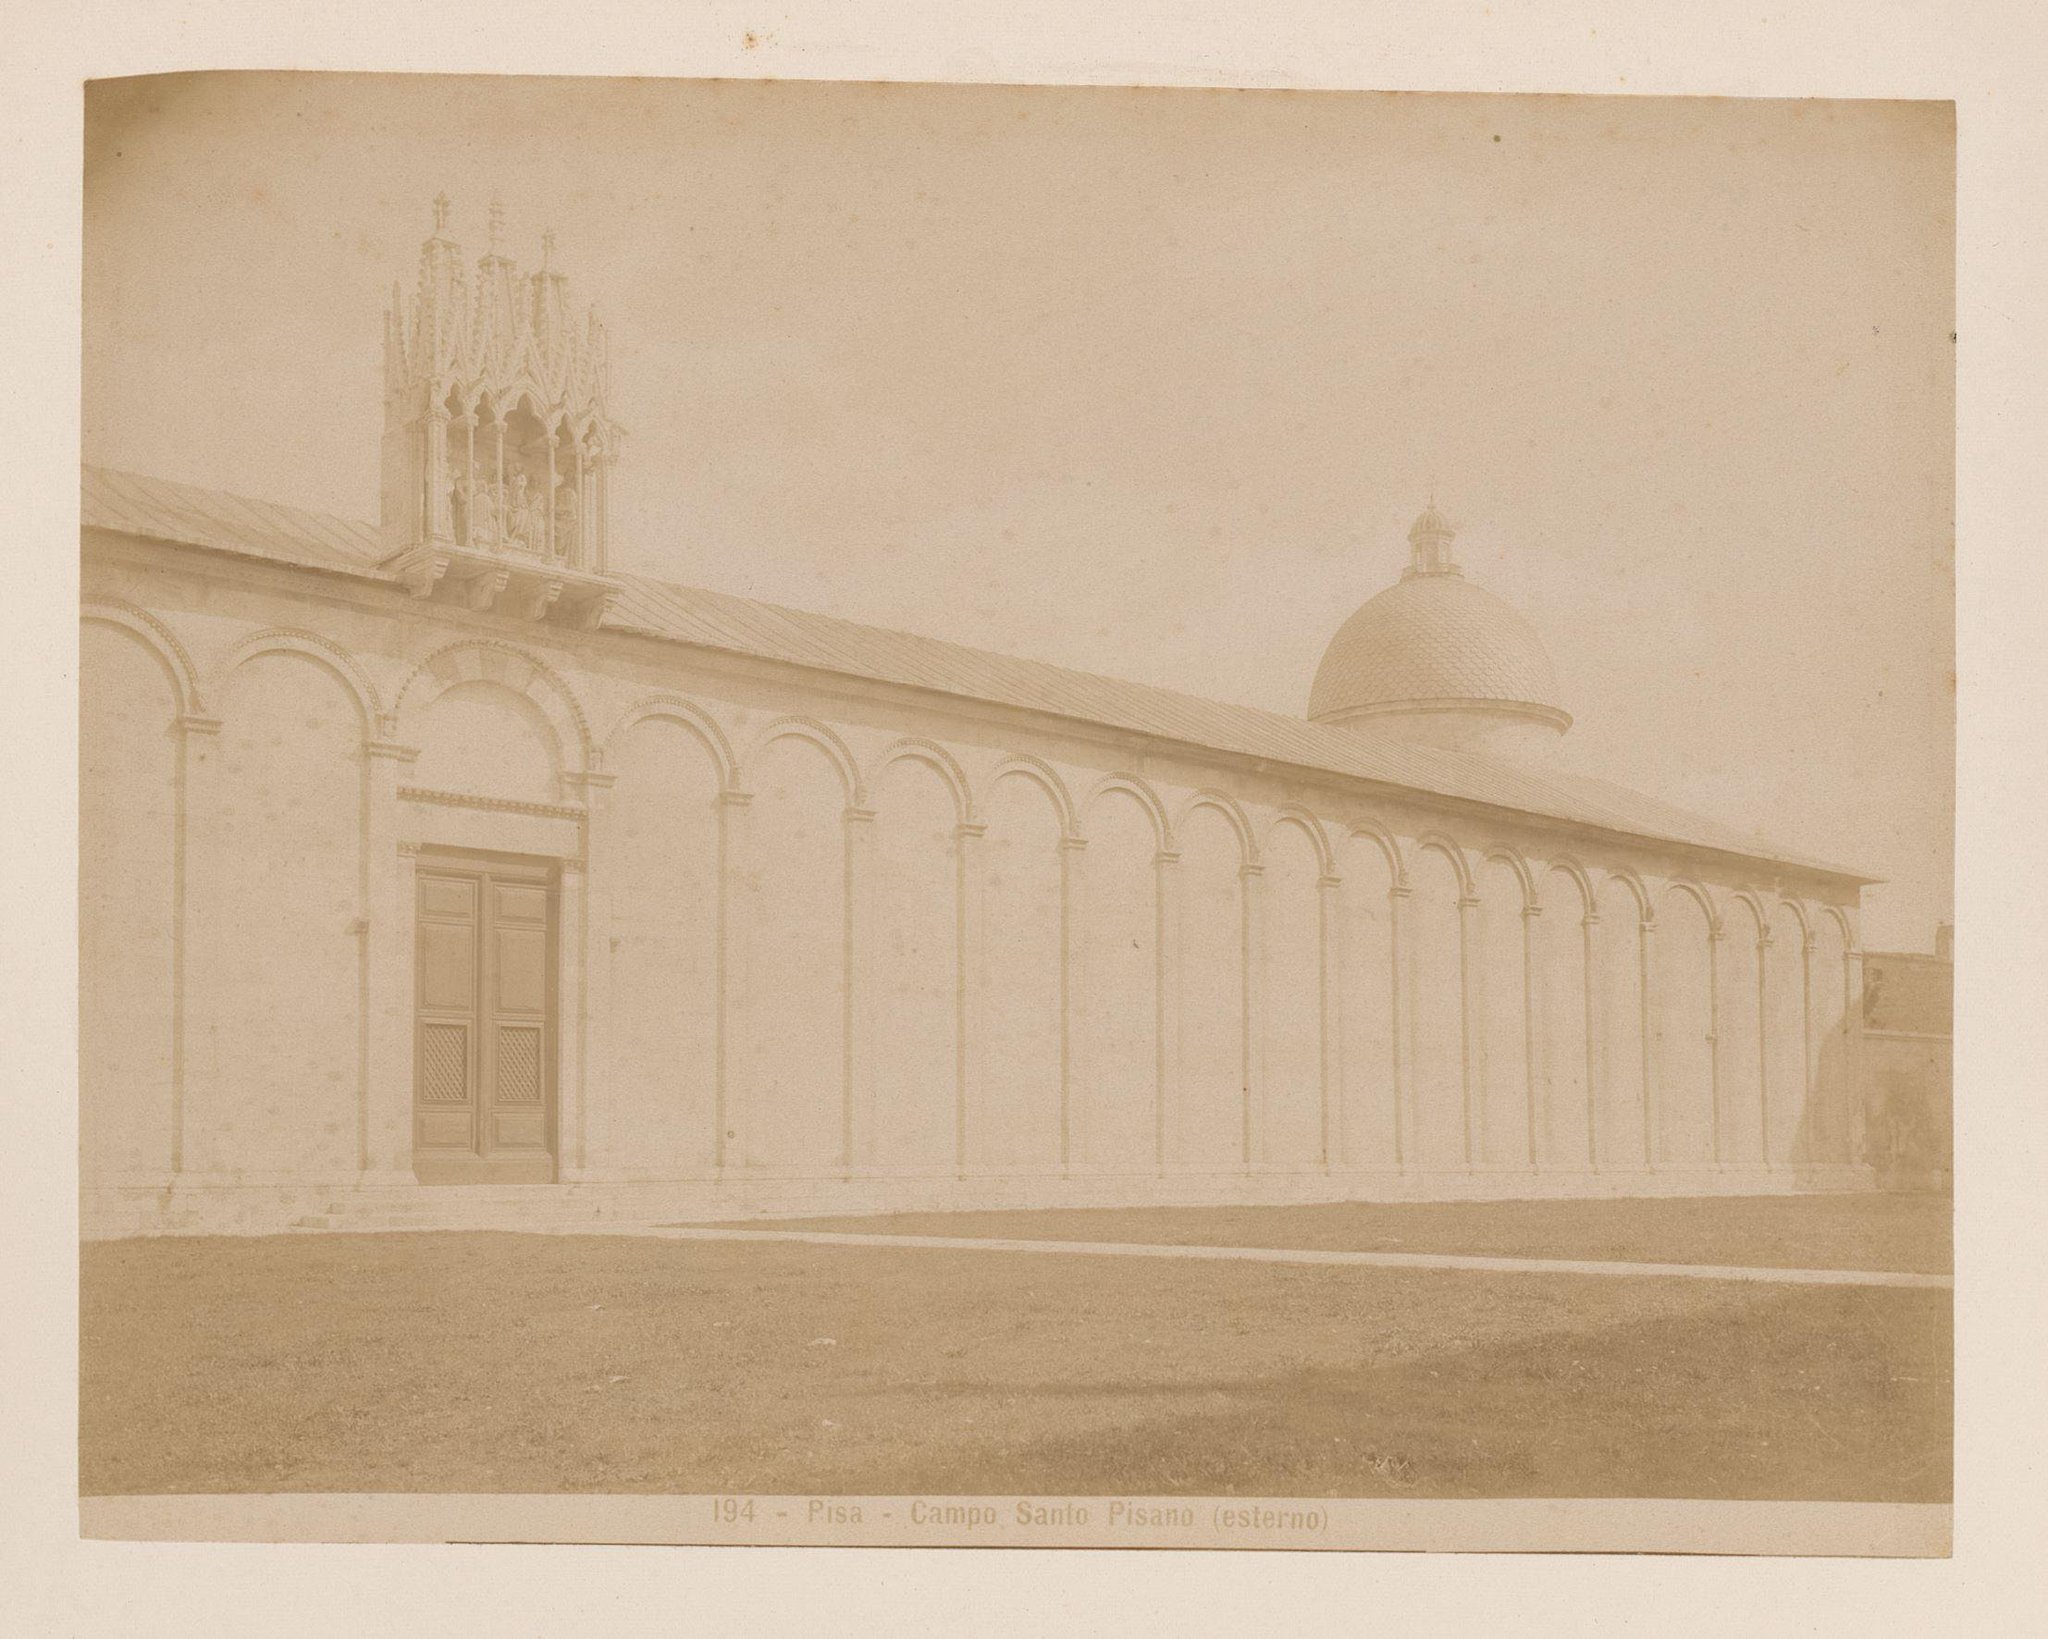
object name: photograph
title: Pisa. Campo Santo Pisano (esterno)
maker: giacomo brogi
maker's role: fotograaf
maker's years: 1822-1881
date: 1860-1881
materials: paper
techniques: albumen print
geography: pisa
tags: churchyard (around church)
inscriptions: number: ‘194’